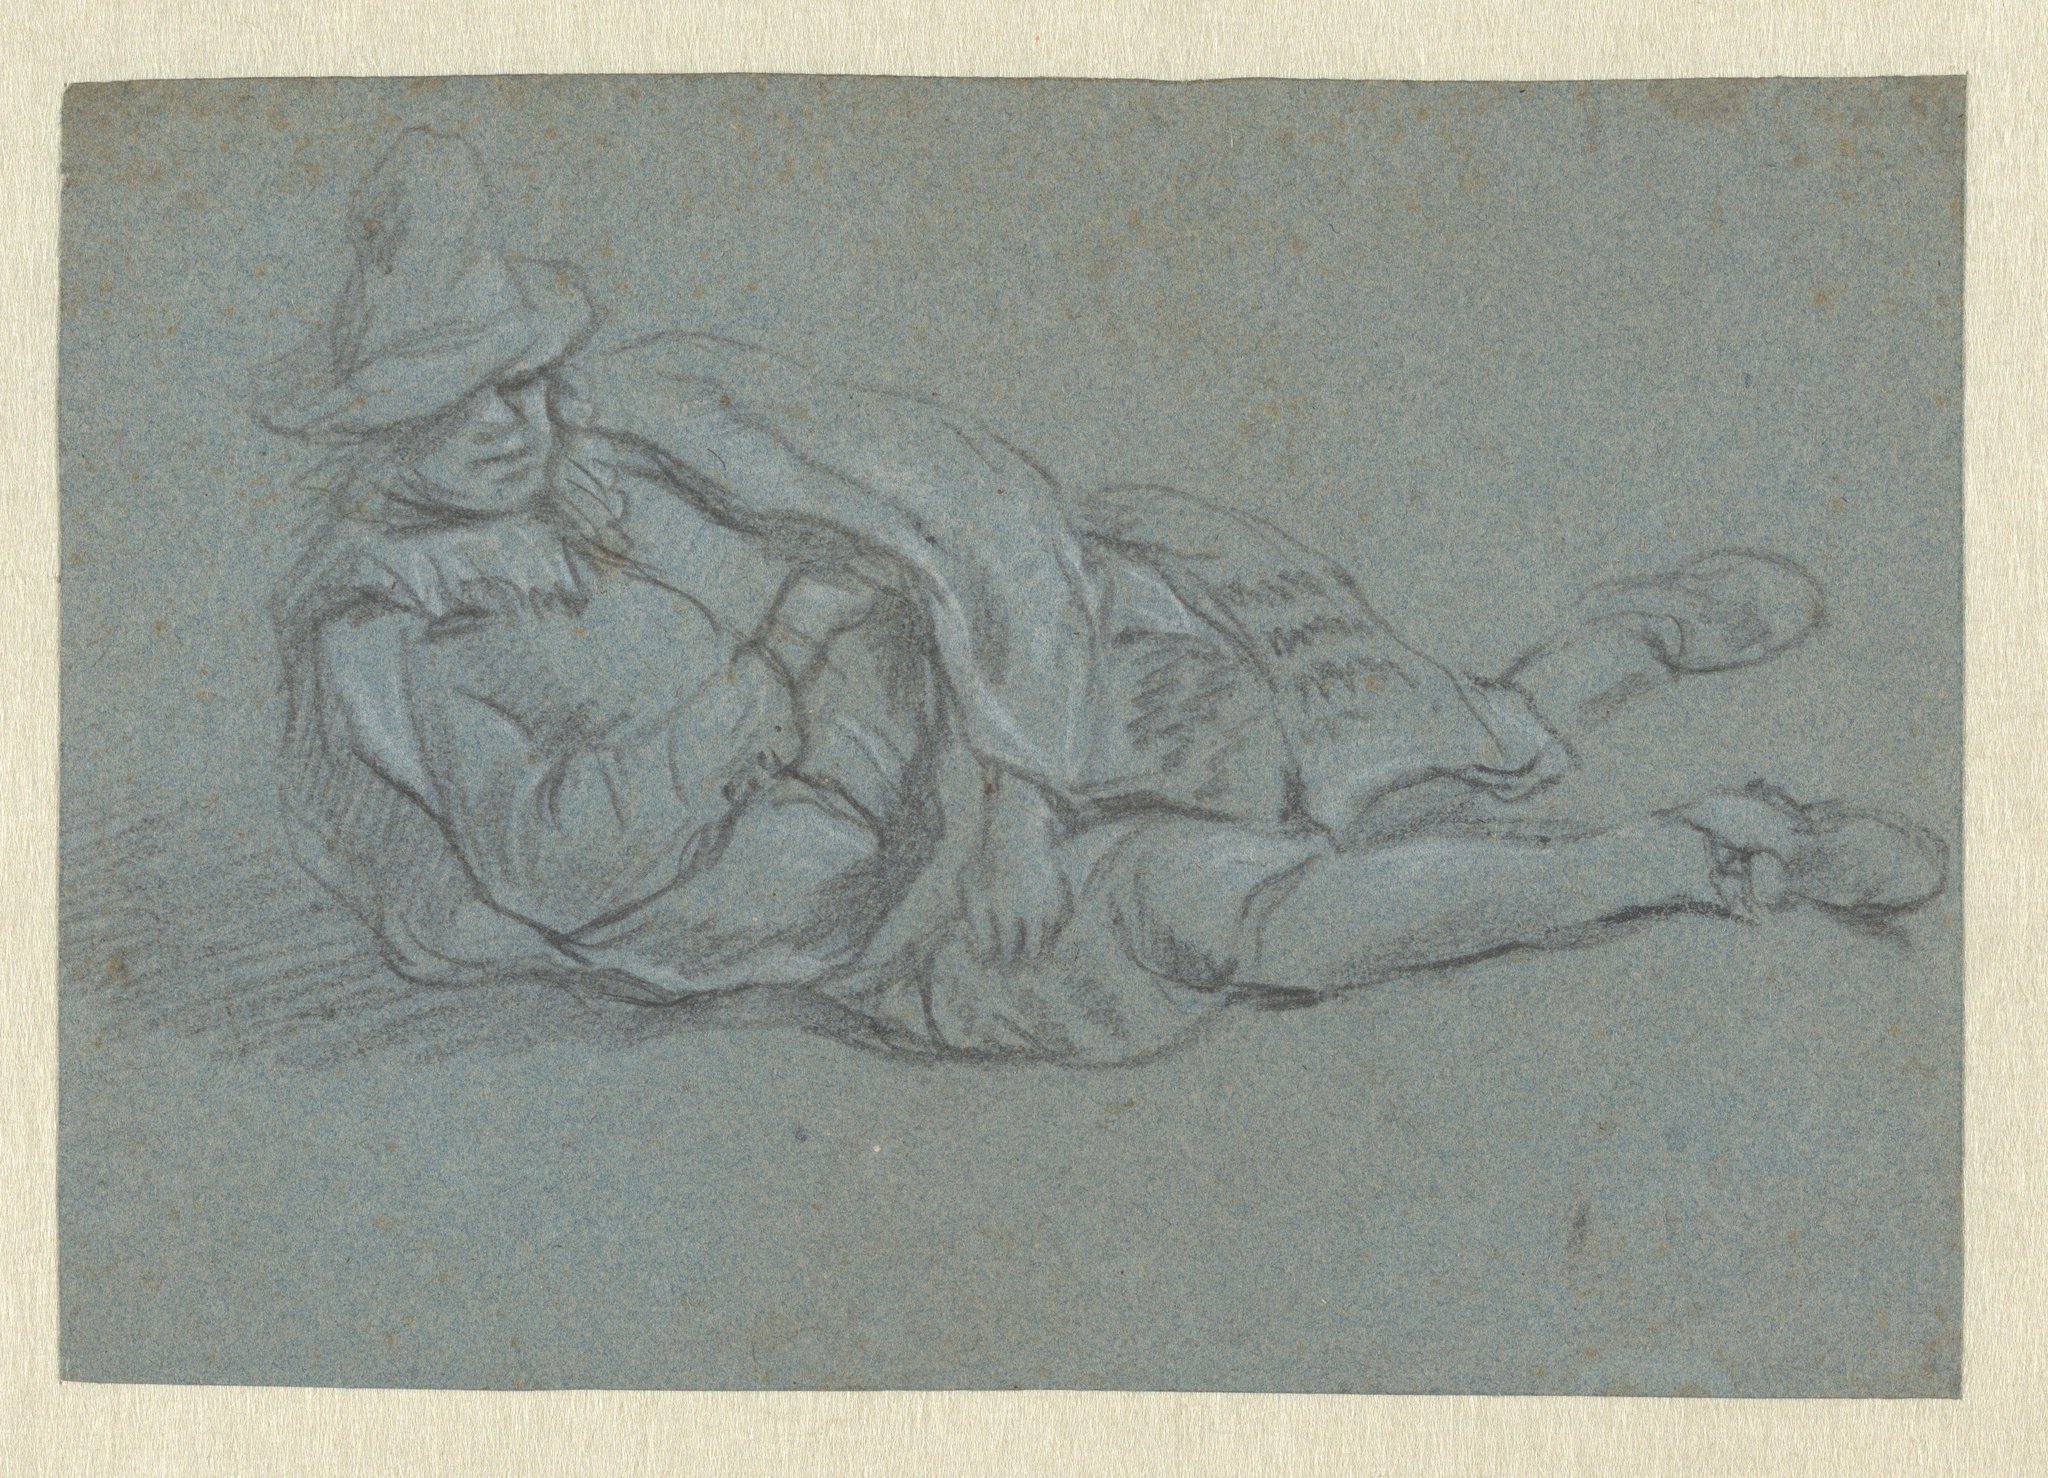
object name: drawing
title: Man Resting on the Ground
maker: Anonymous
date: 1650-1660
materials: chalk, paper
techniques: drawing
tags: lying figure